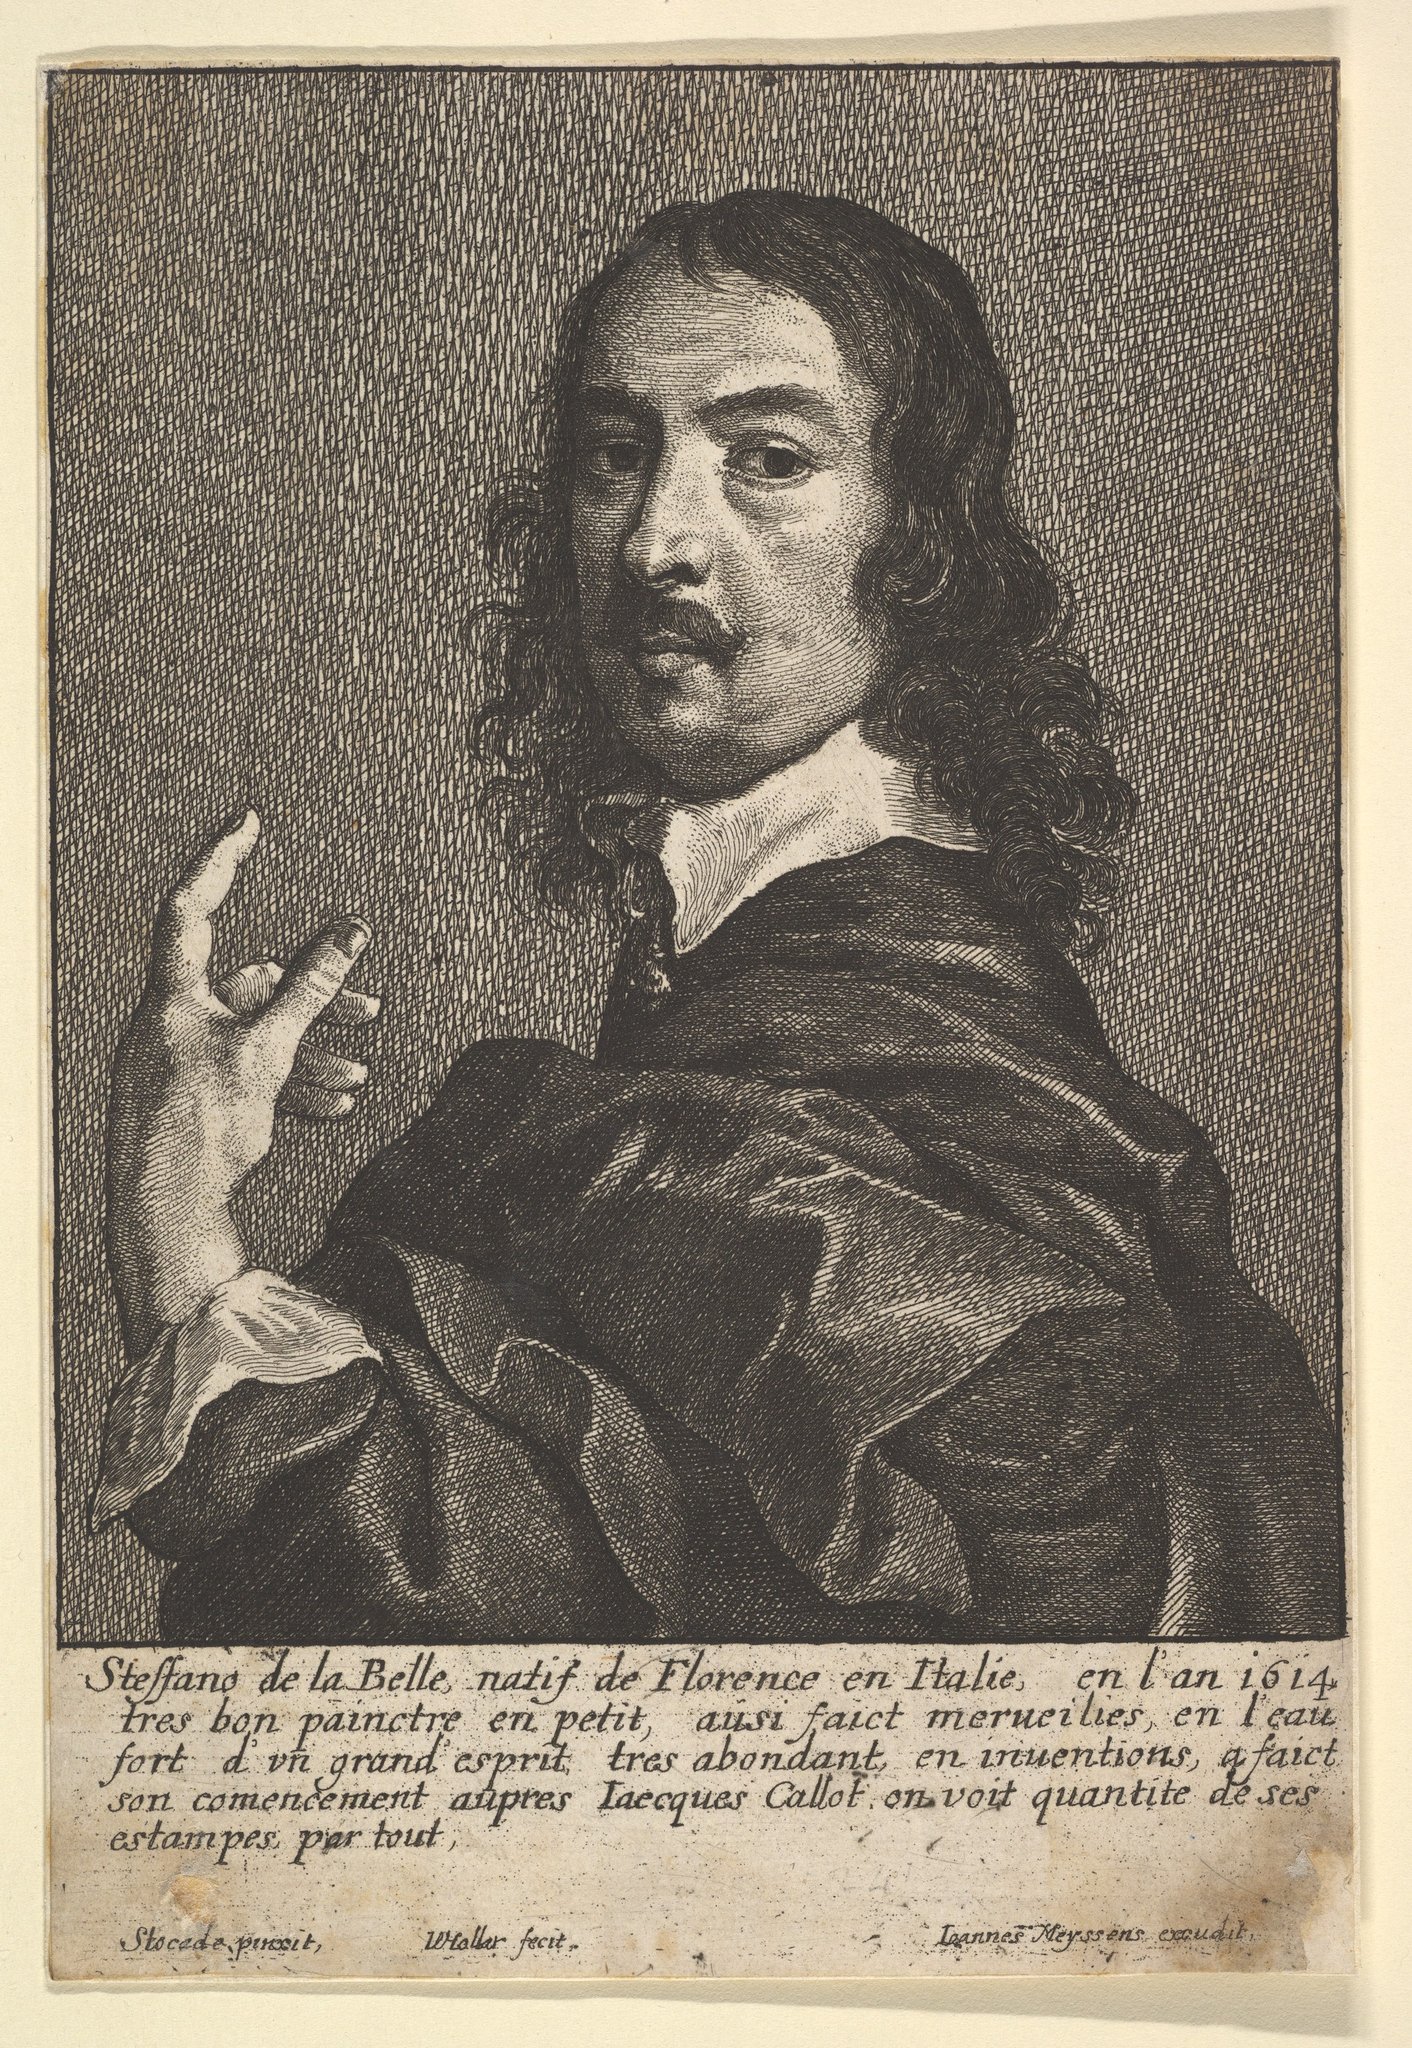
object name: print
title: Stefano della Bella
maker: wenceslaus hollar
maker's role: artist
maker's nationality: bohemian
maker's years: 1607-1677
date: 1649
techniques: etching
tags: men,portraits